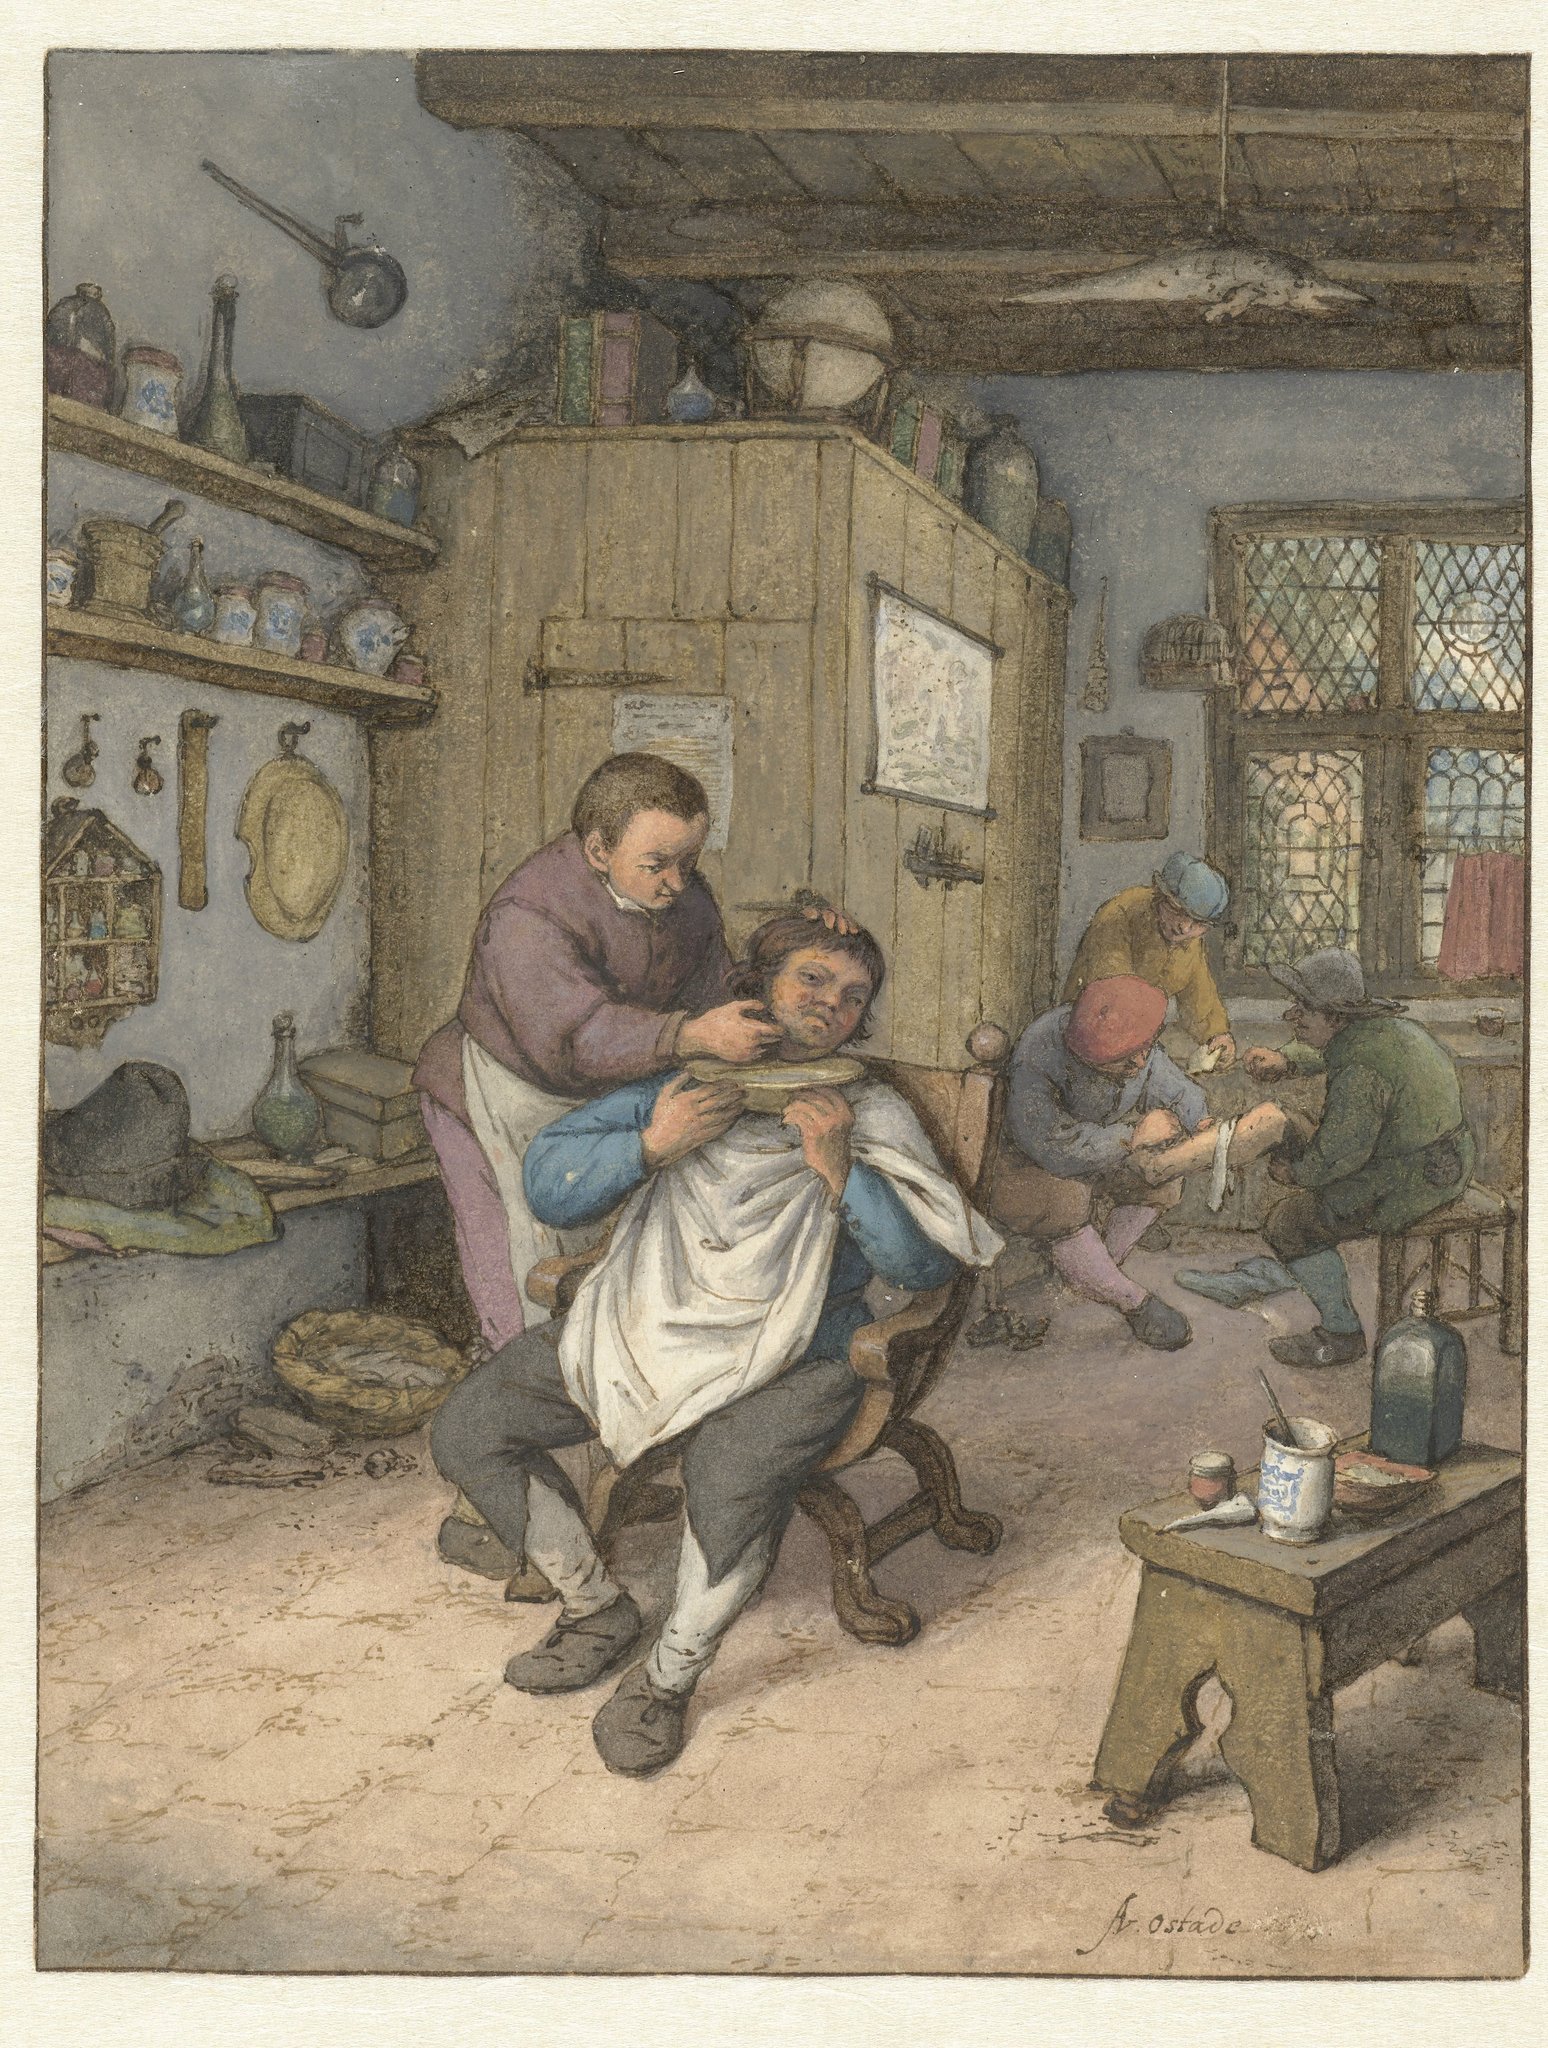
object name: watercolor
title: A Barbershop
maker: adriaen van ostade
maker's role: draughtsman, painter, print maker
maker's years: 1610-1685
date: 1673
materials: paint, paper, watercolor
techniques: brush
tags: barber; surgeon, barber, barbershop, beard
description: A hairdresser is lathering a customer’s chin, before shaving him. The man is holding a bowl himself, to catch the soap and hair. At the back of the shop, the barber – both surgeon and haircutter – is binding a patient’s shin, helped by an assistant. The shop is decorated with the mysterious implements of the barber’s trade: bottles and pots, a distiller’s flask and a mounted fish.